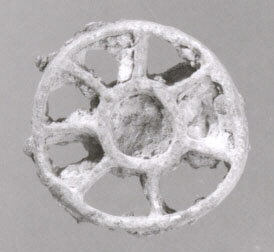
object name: stamp seal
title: Compartmented stamp seal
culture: bactria-margiana archaeological complex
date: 2333-1668 BCE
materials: copper alloy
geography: bactria-margiana